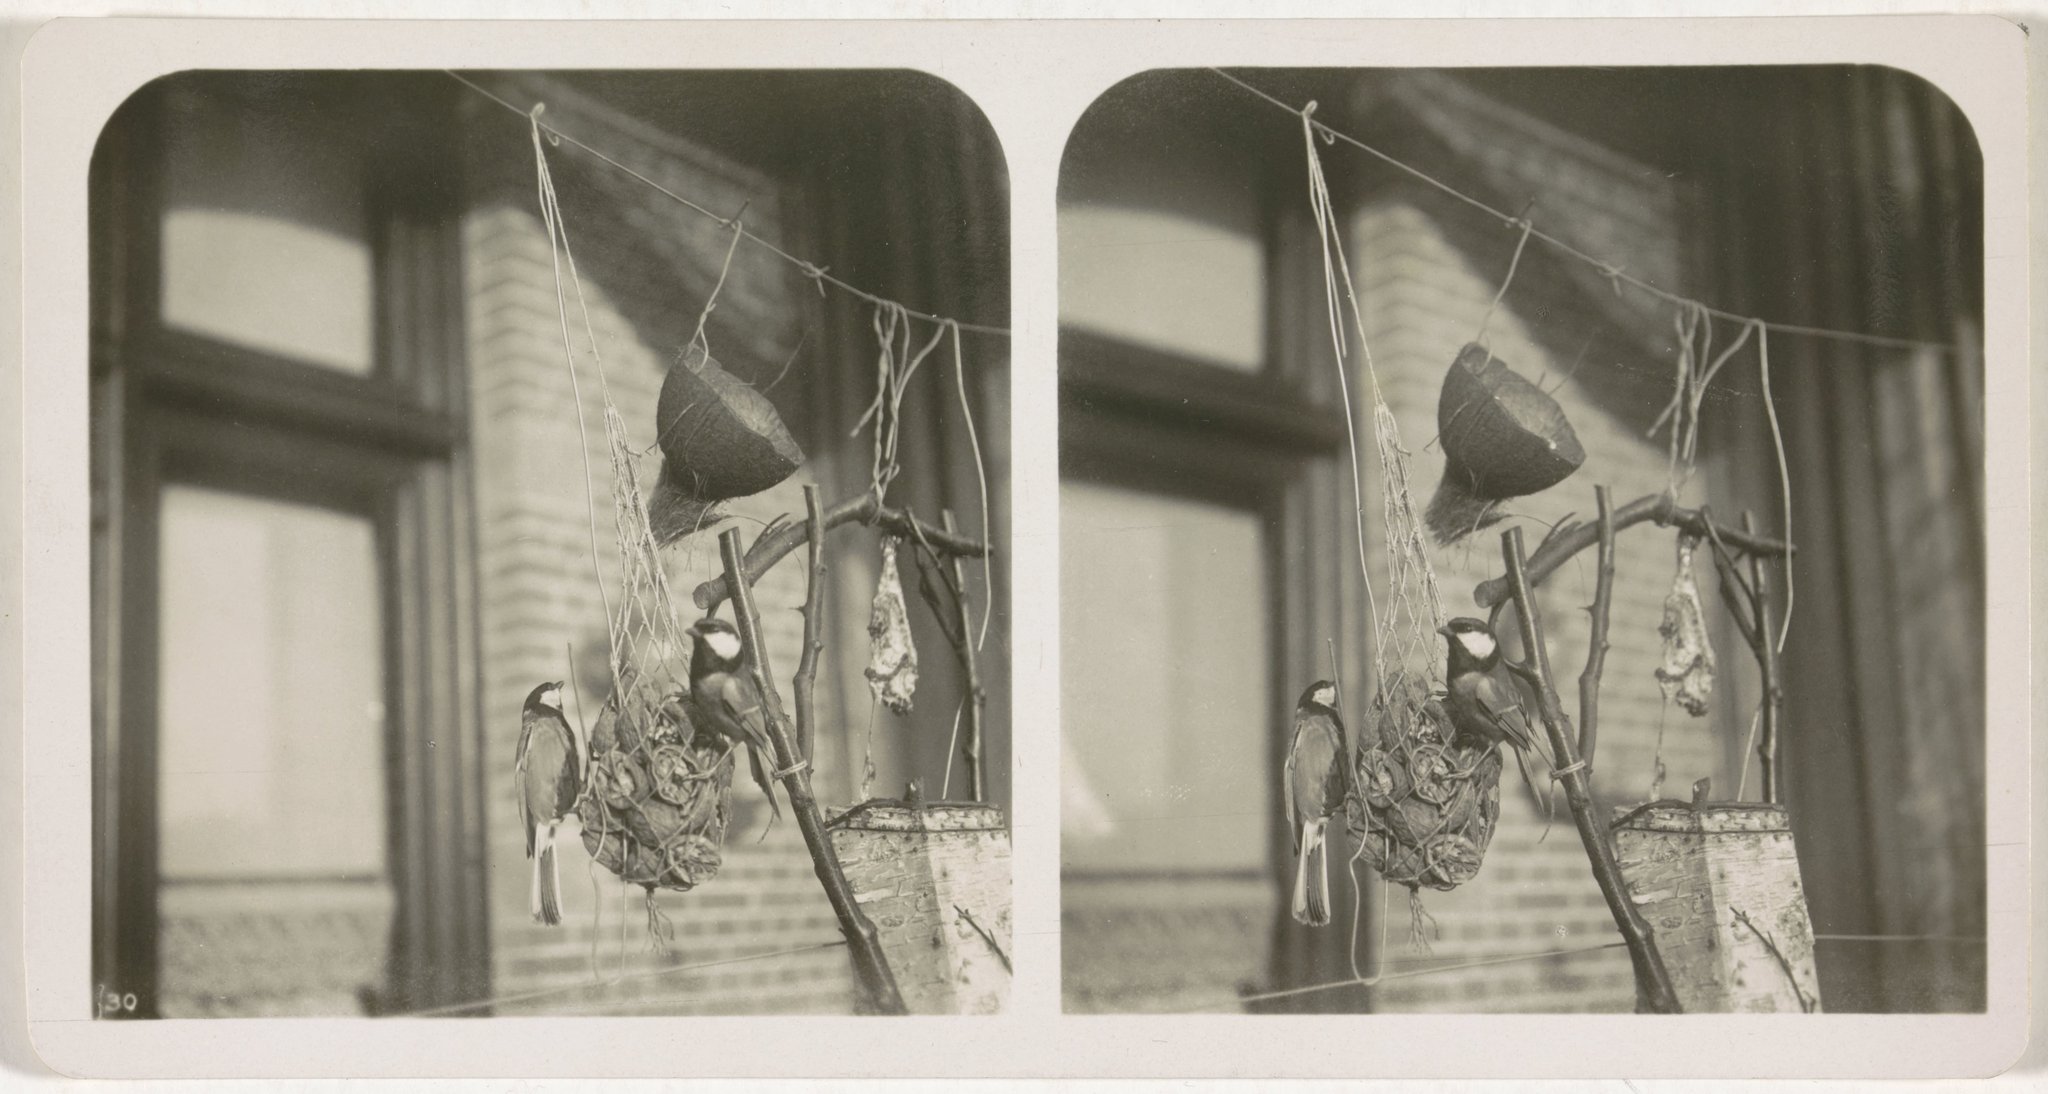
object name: stereograph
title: Les oiseaux et leurs nids / 2e Série Les oiseaux chanteurs (Suite).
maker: adolphe burdet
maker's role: fotograaf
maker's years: 1860-1940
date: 1870-1940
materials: photographic support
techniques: gelatin silver print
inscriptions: label: ‘30 / Parus major L. / Mésange charbonnière / Koolmees...’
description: Linksonder op de foto links staat het nummer 30. Uit serie van 25 stereofoto's.